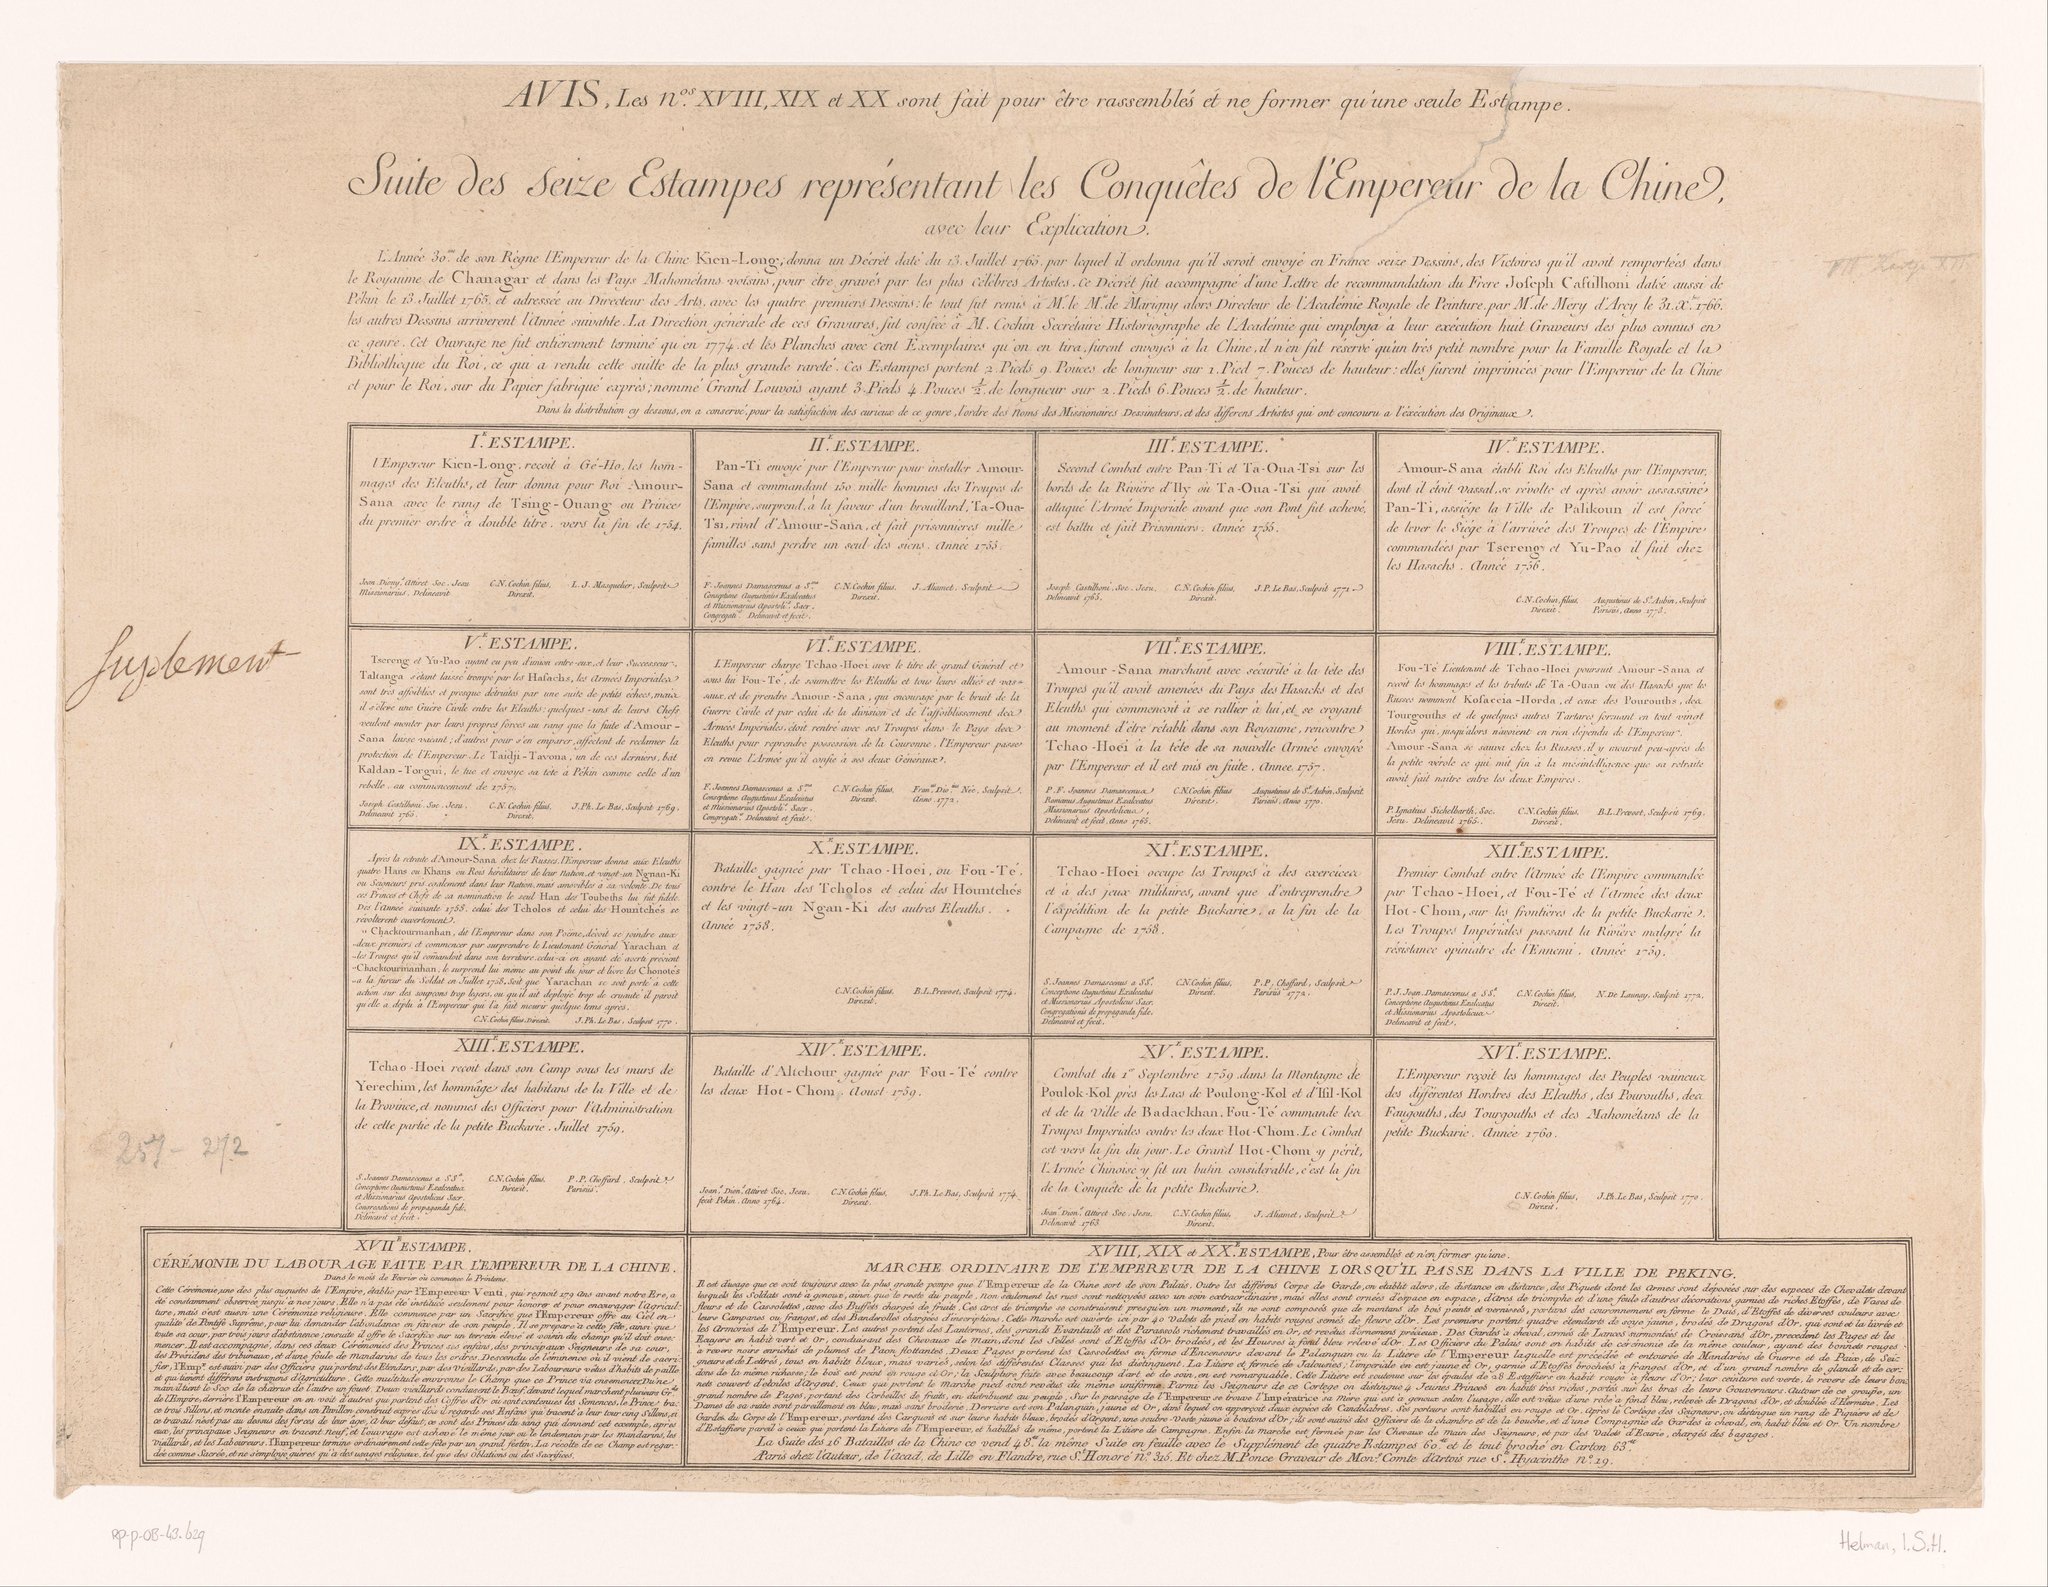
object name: print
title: Tabel met beschrijvende tekst bij twintig prenten, mogelijk gebruikt als omslag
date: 1783-1785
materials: paper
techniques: engraving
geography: paris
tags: letters, alphabet, script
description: Beschrijvende tekst bij een versie van de serie 'Conquêtes de l' Empereur de la Chine' met afbeeldingen van de veroveringen van keizer Qianlong van China, uitgegeven door Helman tussen 1783-1785.